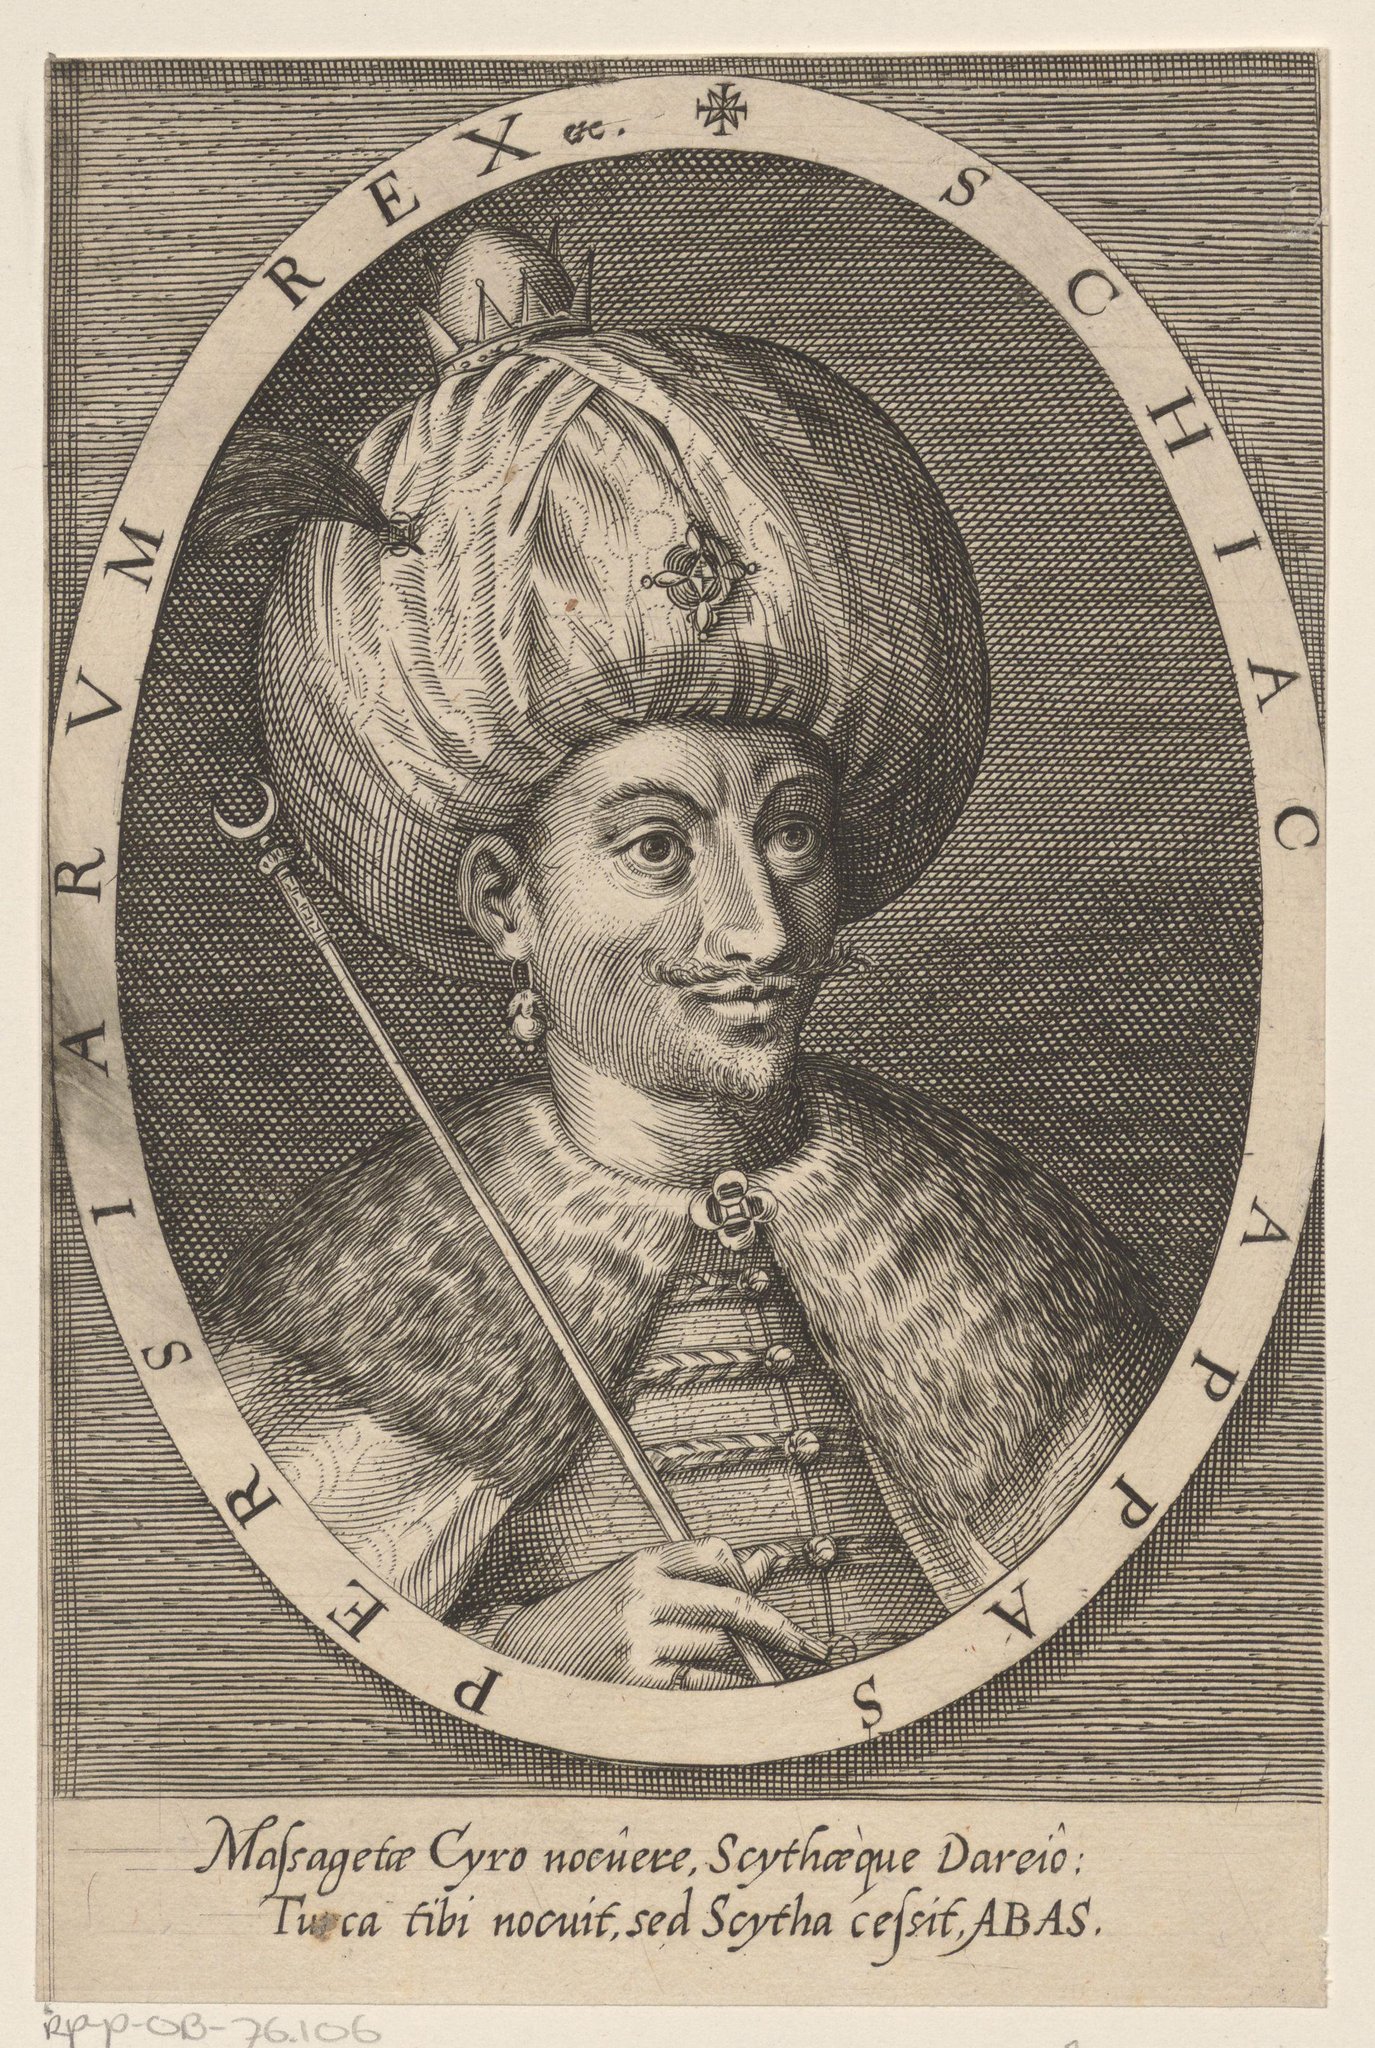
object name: print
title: Portret van Abbas I, sjah van Perzië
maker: dominicus custos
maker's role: print maker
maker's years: 1560-1615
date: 1586-1615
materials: paper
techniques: engraving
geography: augsburg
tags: sceptre, staff (symbol of sovereignty), head-gear: turban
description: Portret van Abbas I in een ovale omlijsting met randschrift. Hij draagt een tulband en heeft een scepter in zijn rechterhand. In de ondermarge twee regels Latijnse tekst.